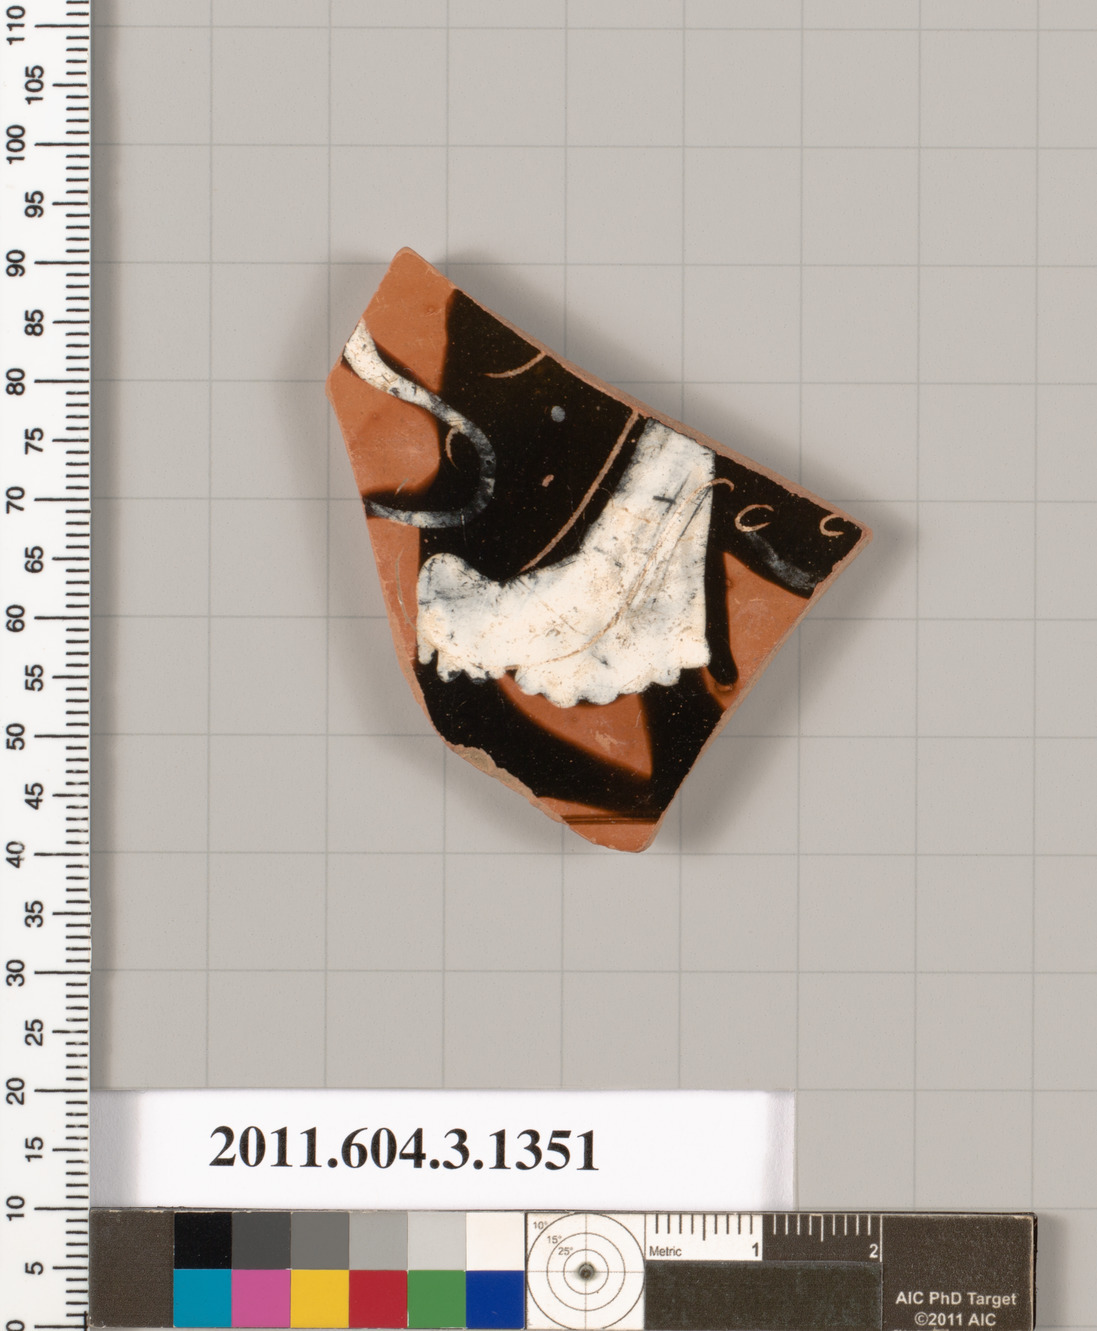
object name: skyphos fragment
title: Terracotta fragment of a skyphos (deep drinking cup)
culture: greek, attic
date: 500-468 BCE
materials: terracotta